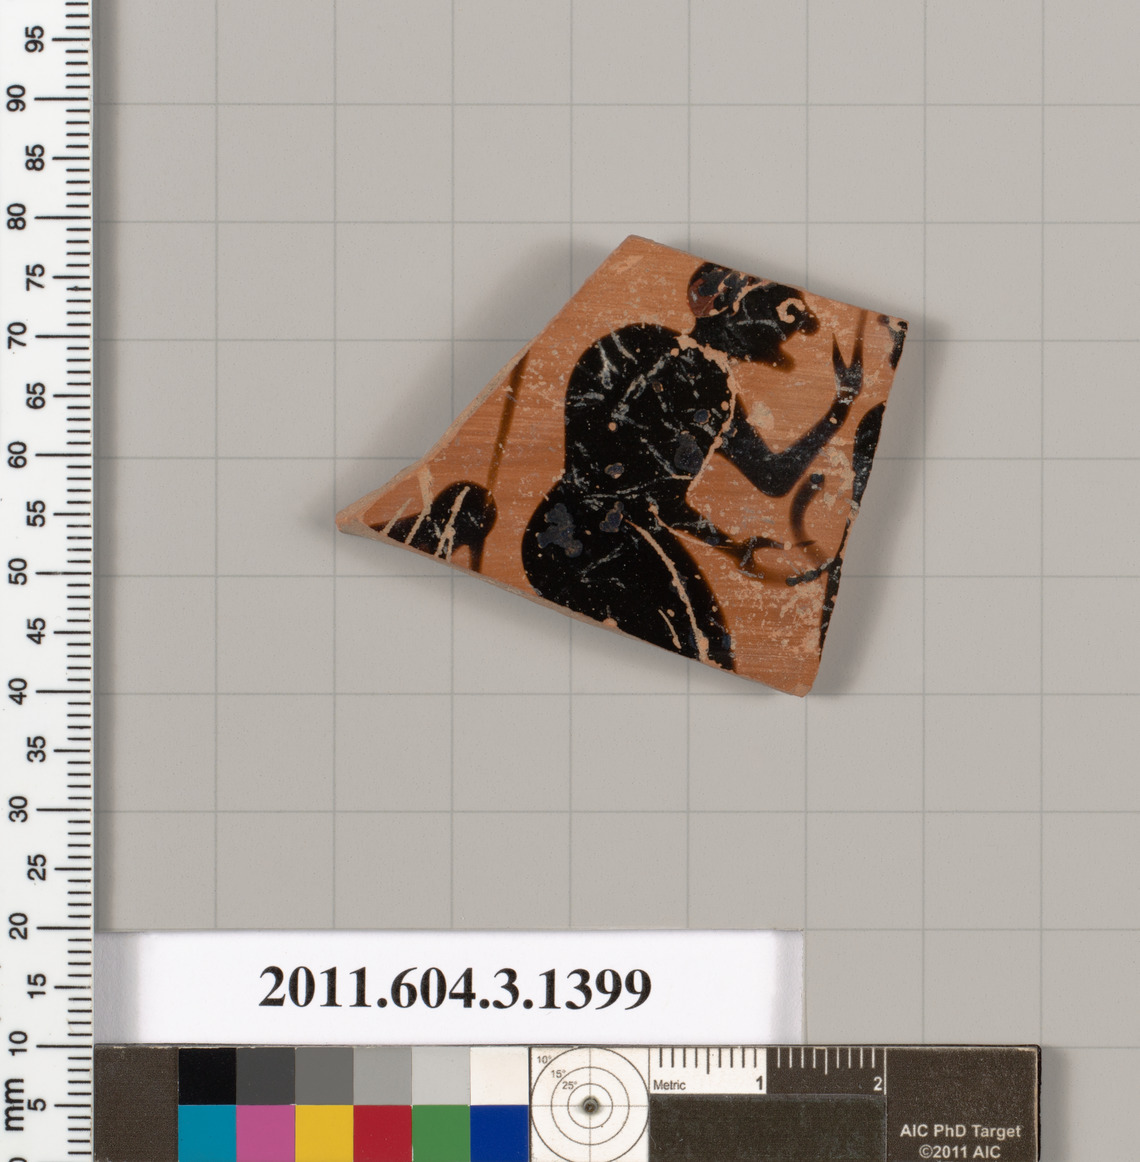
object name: skyphos fragment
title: Terracotta fragment of a skyphos (deep drinking cup)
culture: greek, attic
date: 534-468 BCE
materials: terracotta